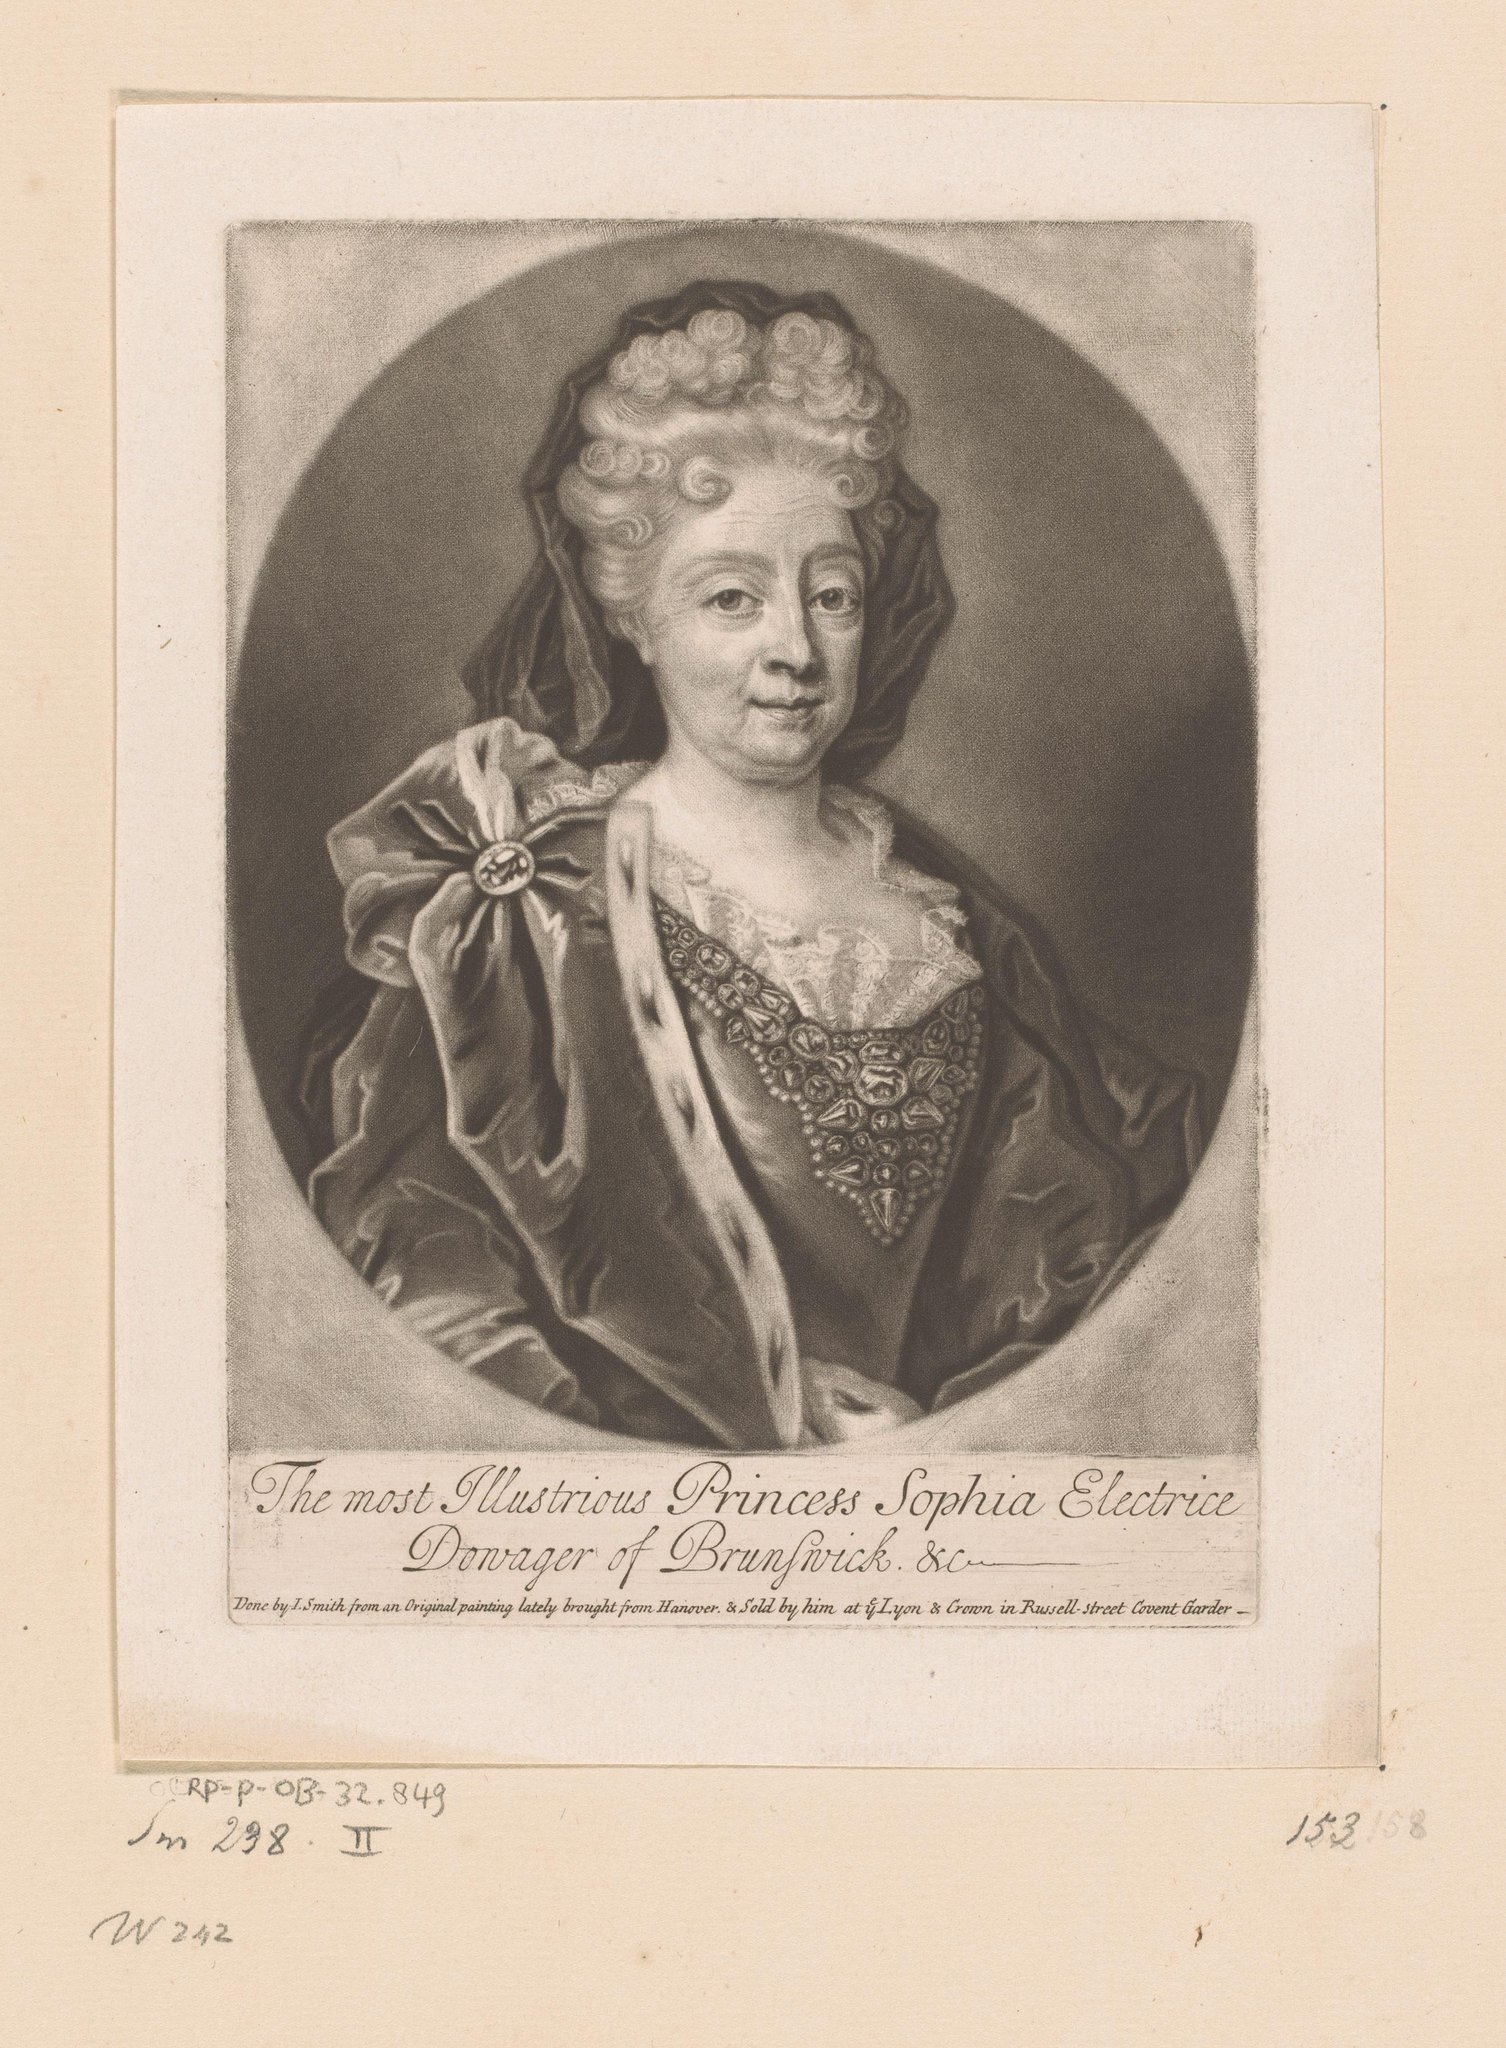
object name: print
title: Portret van Sophia van Hannover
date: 1678-1742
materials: paper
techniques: mezzotint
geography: london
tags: the hague, historical persons, king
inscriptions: collector's mark: Lugt 240